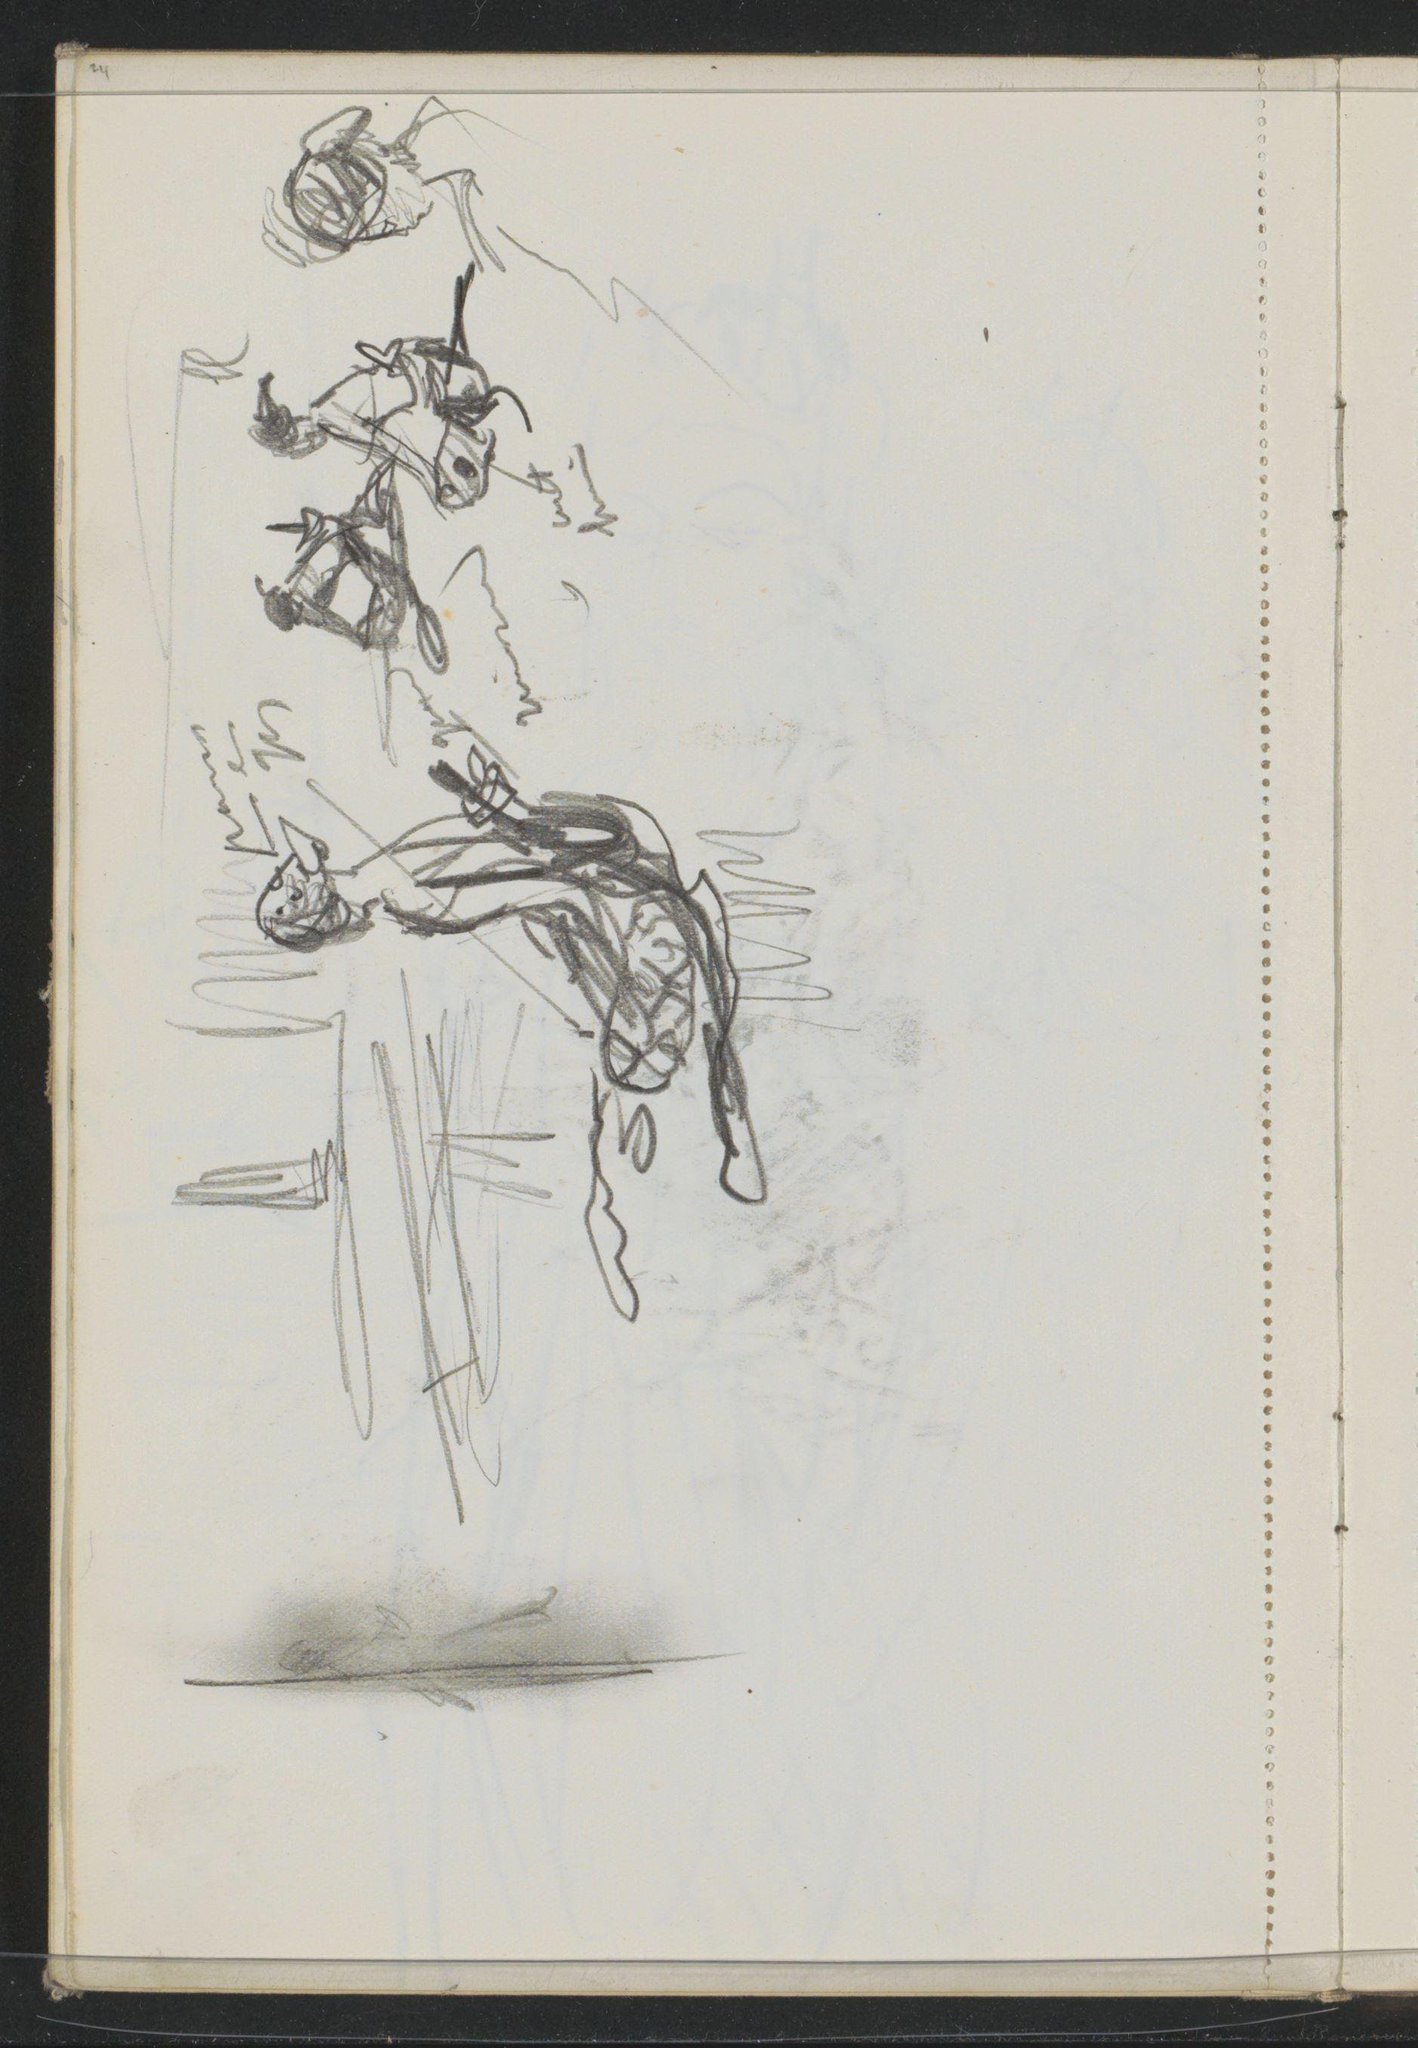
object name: sketchbook leaf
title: Zittende Indonesiërs met zwaarden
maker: marius bauer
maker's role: draughtsman, print maker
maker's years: 1867-1932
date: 1925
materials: paper, pencil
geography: indonesia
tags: asiatic races and peoples, sitting figure, hacking and thrusting weapons: sword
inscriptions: kleurnotitie, handgeschreven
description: Vermoedelijk dansers in traditioneel kostuum. Pagina 24 uit een schetsboek met 74 bladen.